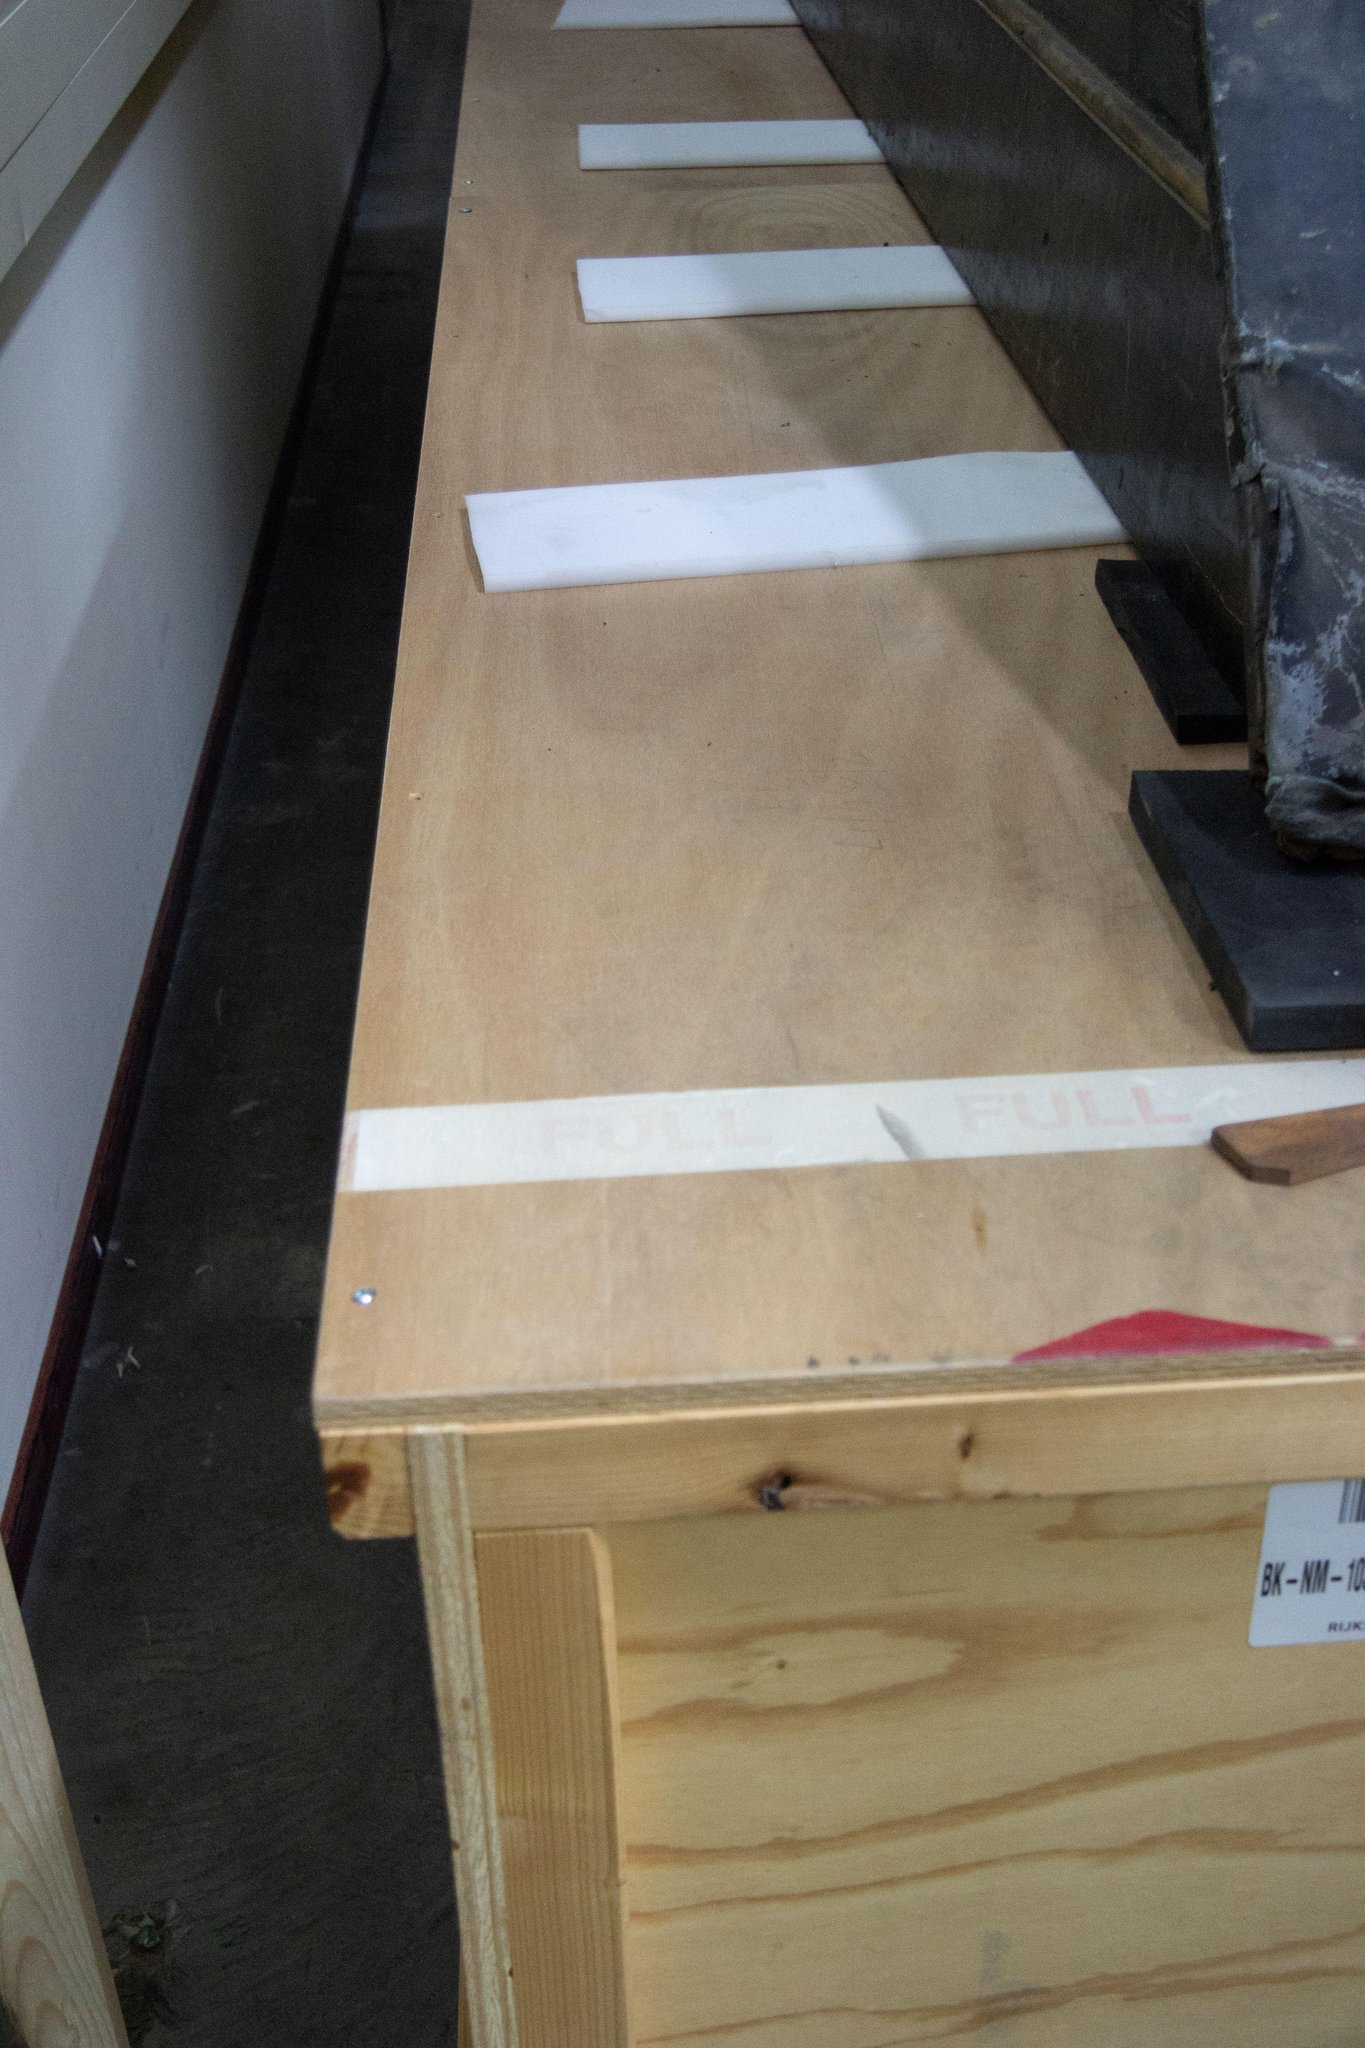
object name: plank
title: Planken van beschilderd eikenhout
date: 1631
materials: wood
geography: northern netherlands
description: Planken van geschilderd eikenhout. Horend bij een balkenzoldering afkomstig uit het huis De Munnik, Wijnstraat 54, Dordrecht.